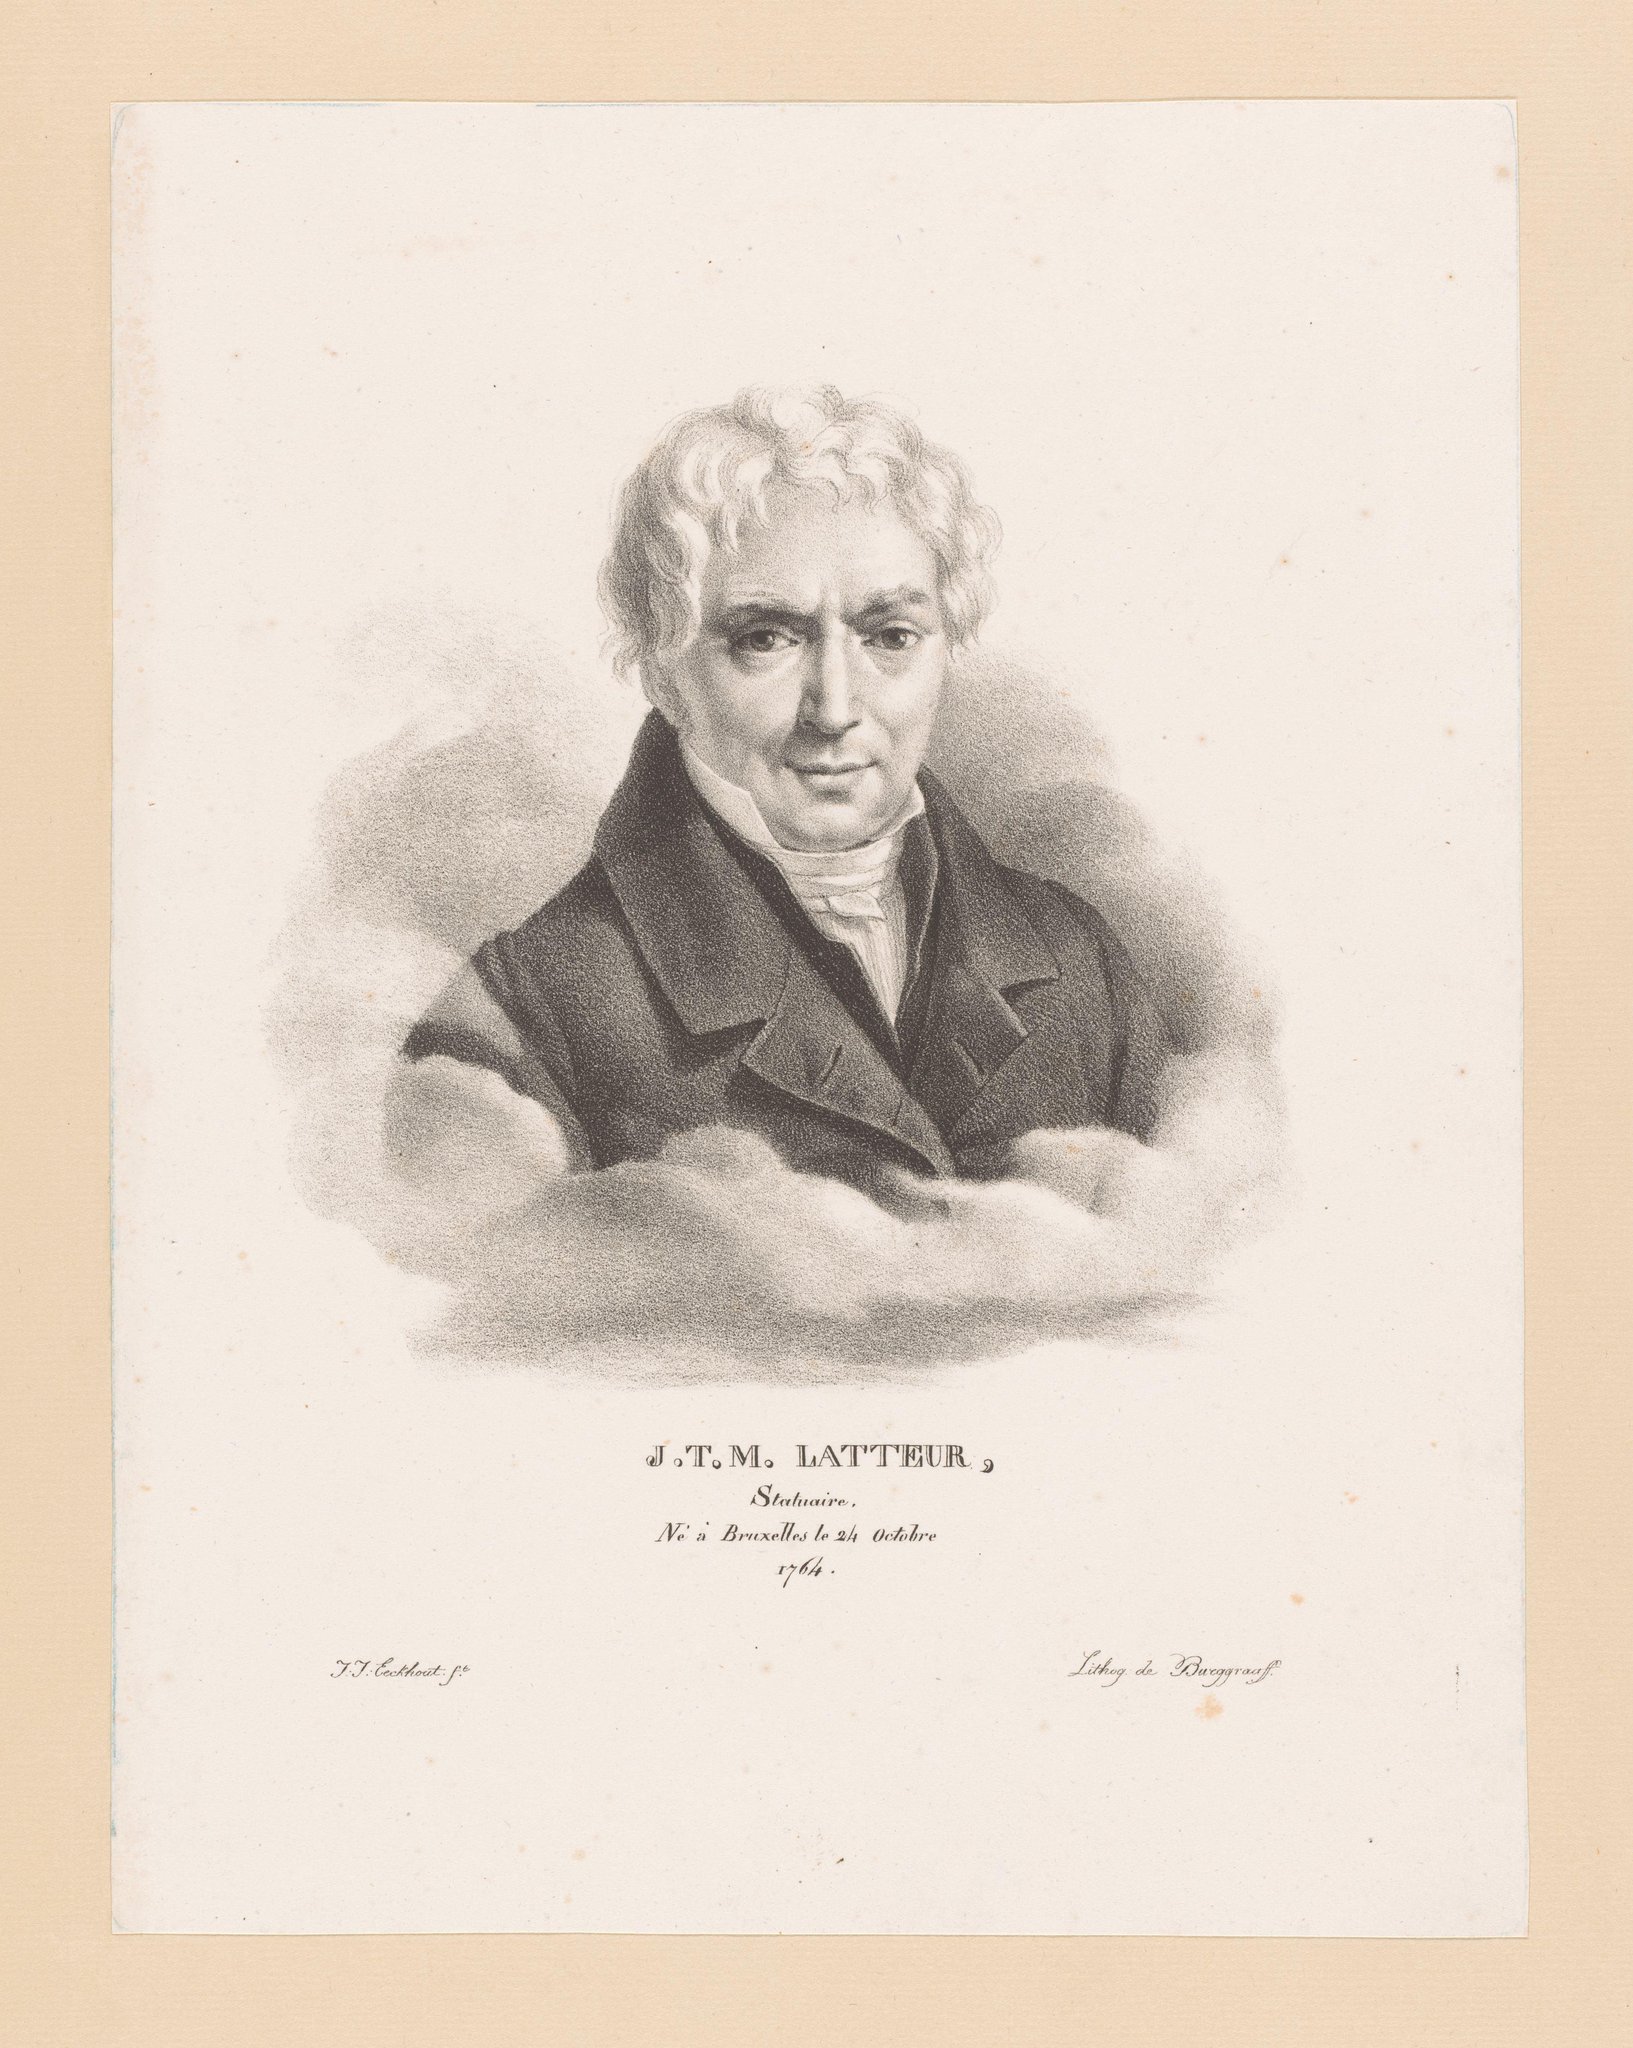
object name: print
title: Portraits des artistes modernes nés dans le Royaume des Pays-Bas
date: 1822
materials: paper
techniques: lithograph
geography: brussels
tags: brussels, sculptor, portrait, self-portrait of sculptor, historical persons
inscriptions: collector's mark: Lugt 2228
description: Prent maakt deel uit van een serie van zestig prenten.